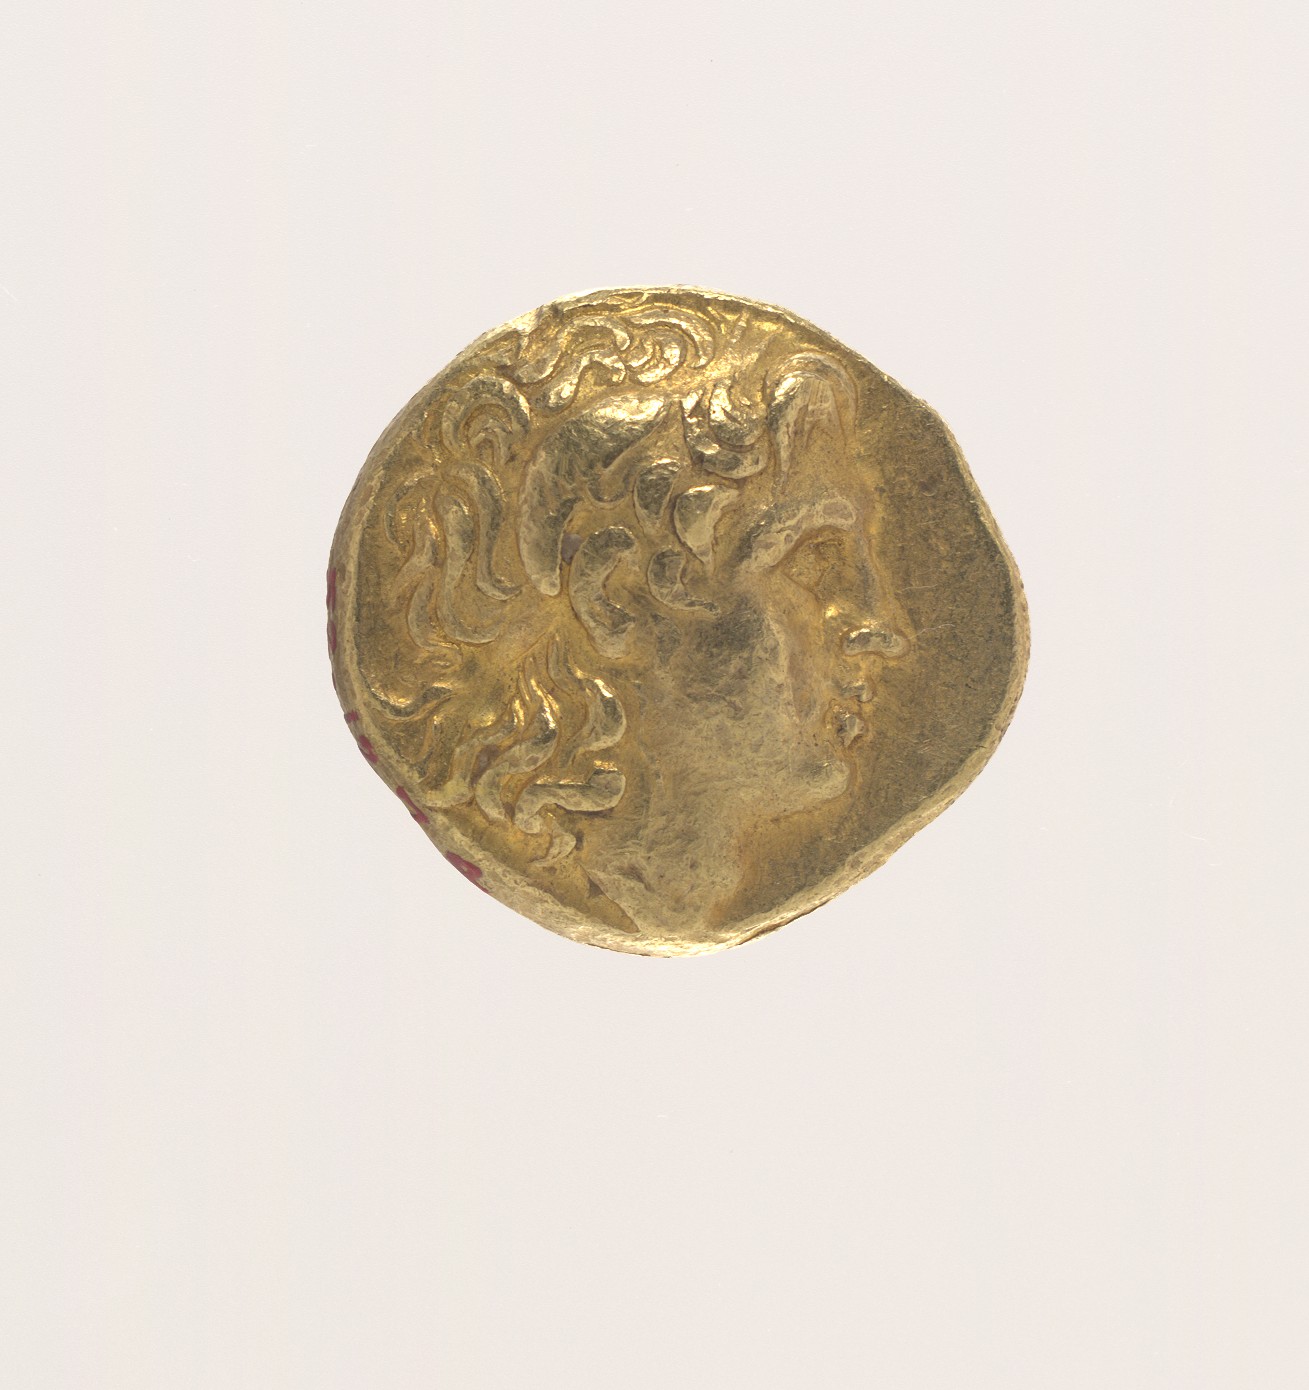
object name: stater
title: Gold stater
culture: greek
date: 286-281 BCE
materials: gold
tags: alexander the great,profiles,athena